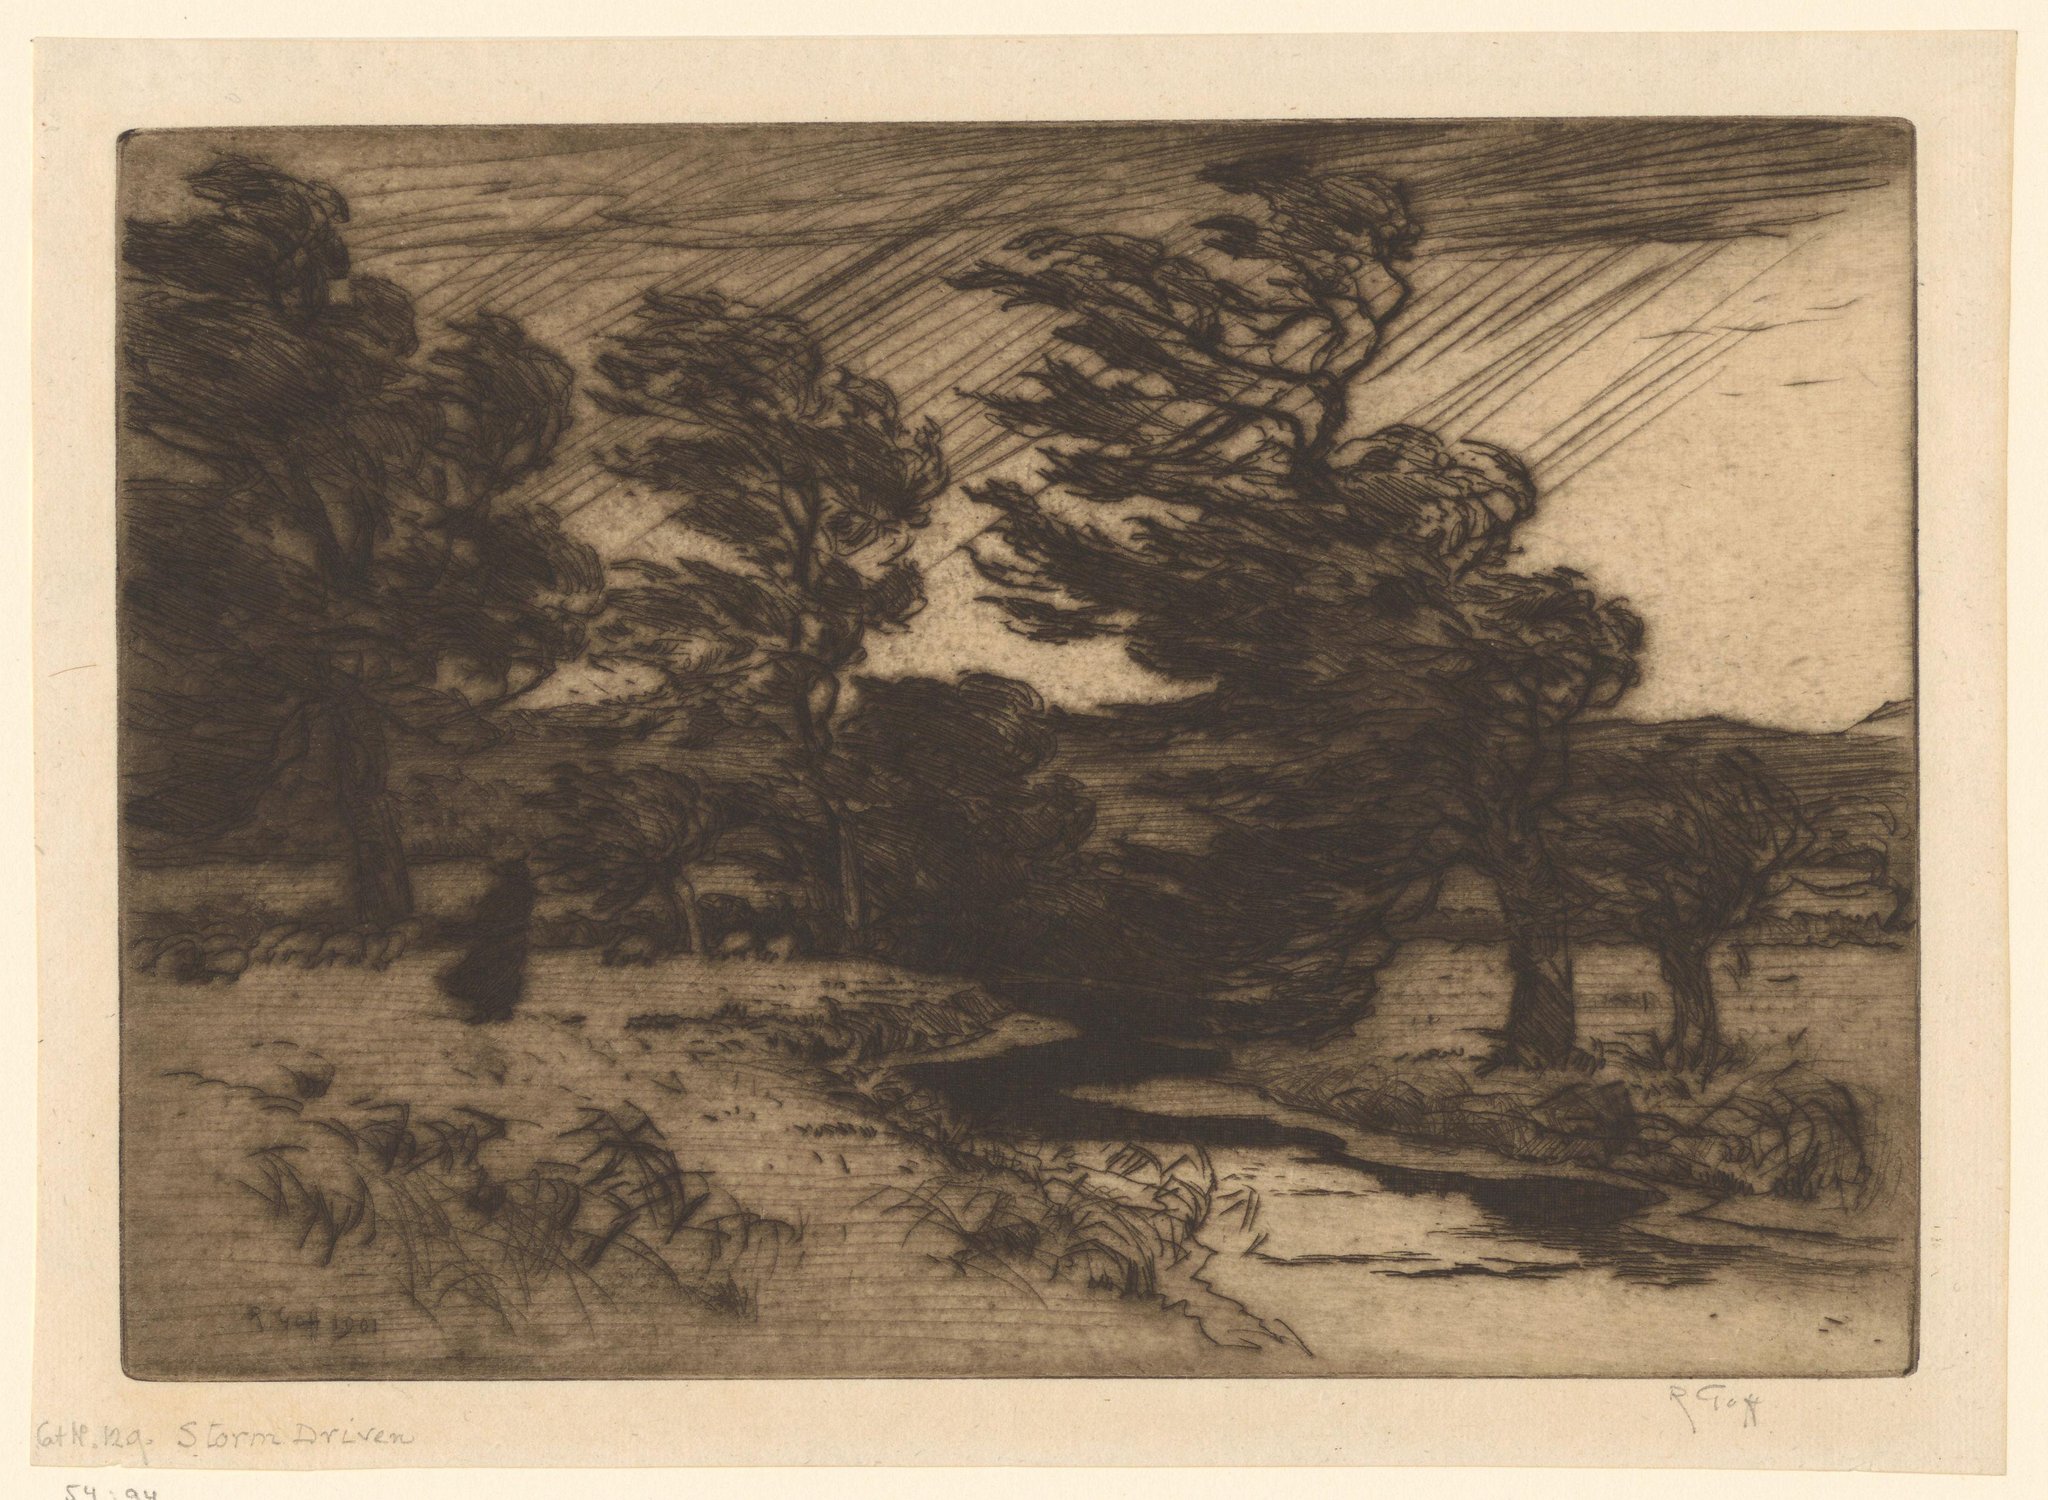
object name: print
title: Landschap met bomen en beek in een storm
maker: robert charles goff (1837-1922)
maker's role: painter, print maker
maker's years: 1837-1922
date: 1901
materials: paper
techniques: drypoint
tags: brook (+ landscape with figures, staffage), storm on land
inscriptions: collector's mark: Lugt 2228, collector's mark: Lugt 2760, annotation: ‘Storm driven’